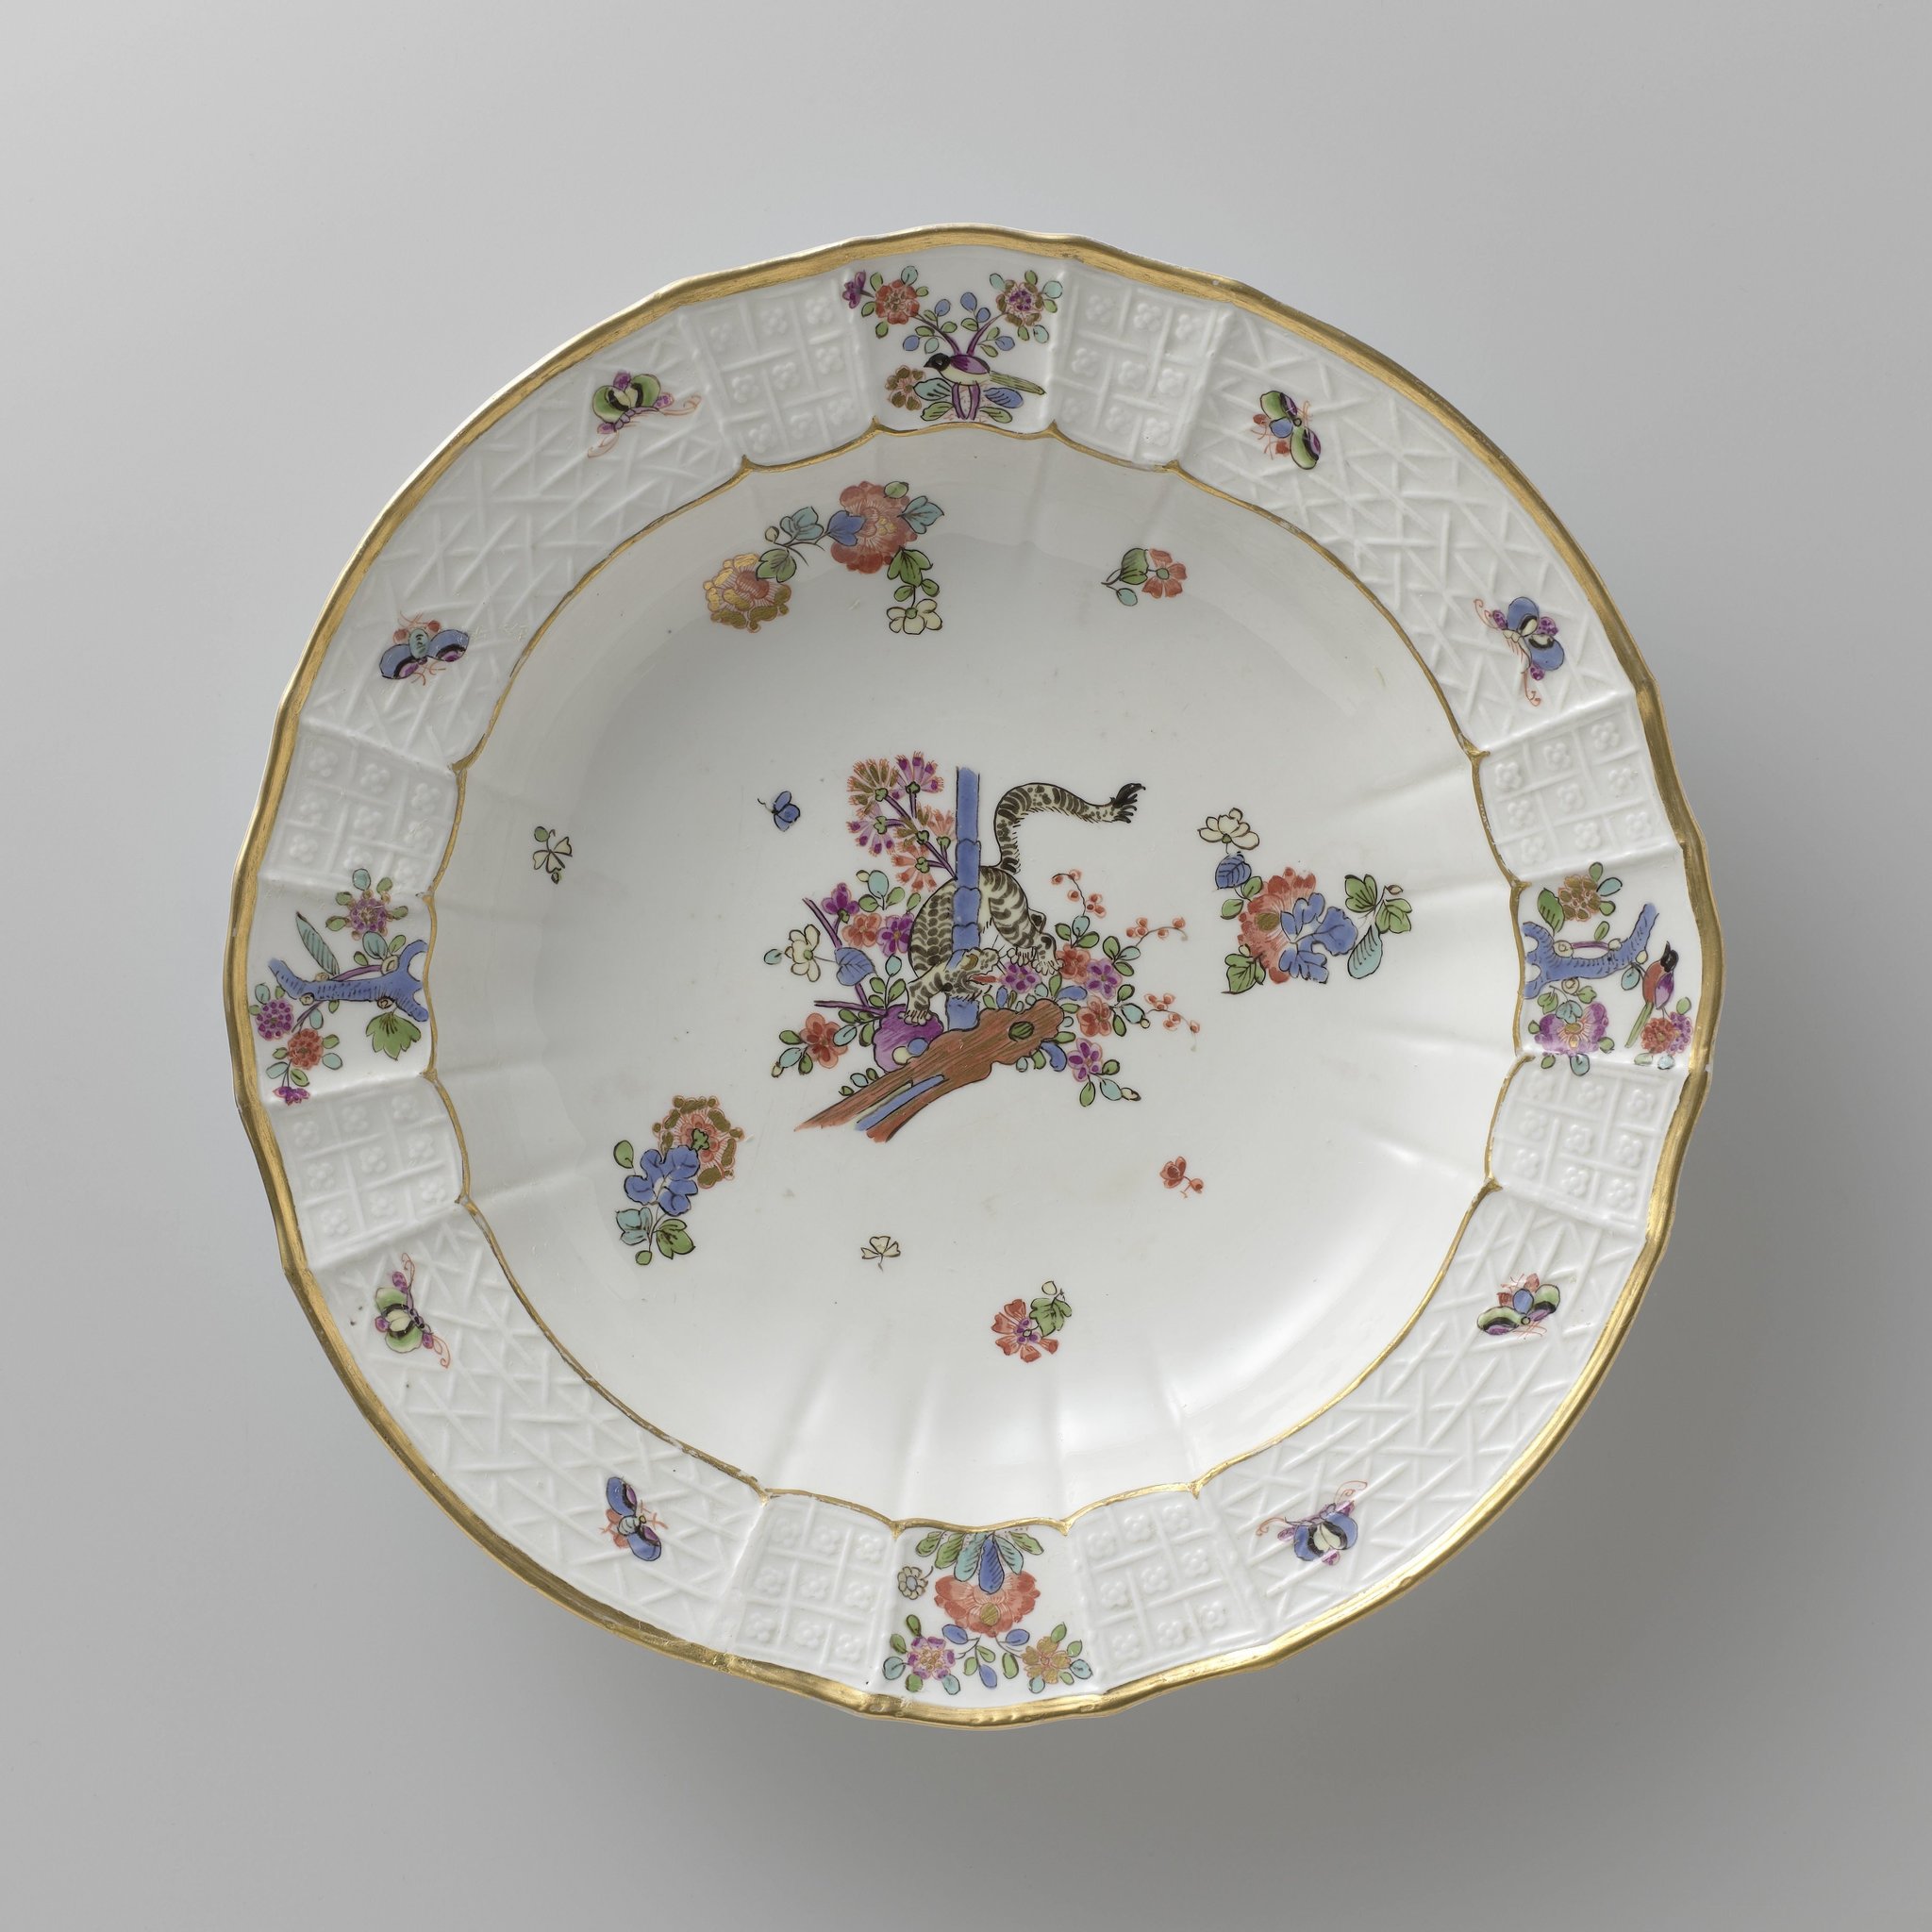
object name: soup plate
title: Soepbord, veelkleurig beschilderd met een Kakiemon-decor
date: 1740-1745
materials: porcelain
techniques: painted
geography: meissen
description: Soepbord van beschilderd porselein. Het bord heeft een geribde en geschulpte rand. Het bord is beschilderd met een tijger, die zich tussen bloemen om een bamboestengel draait, gestrooide Indianische Blumen, vlinders en takken met vogels. De rand is versierd met het 'Altbrandenstein'-patroon. Het bord is gemerkt.